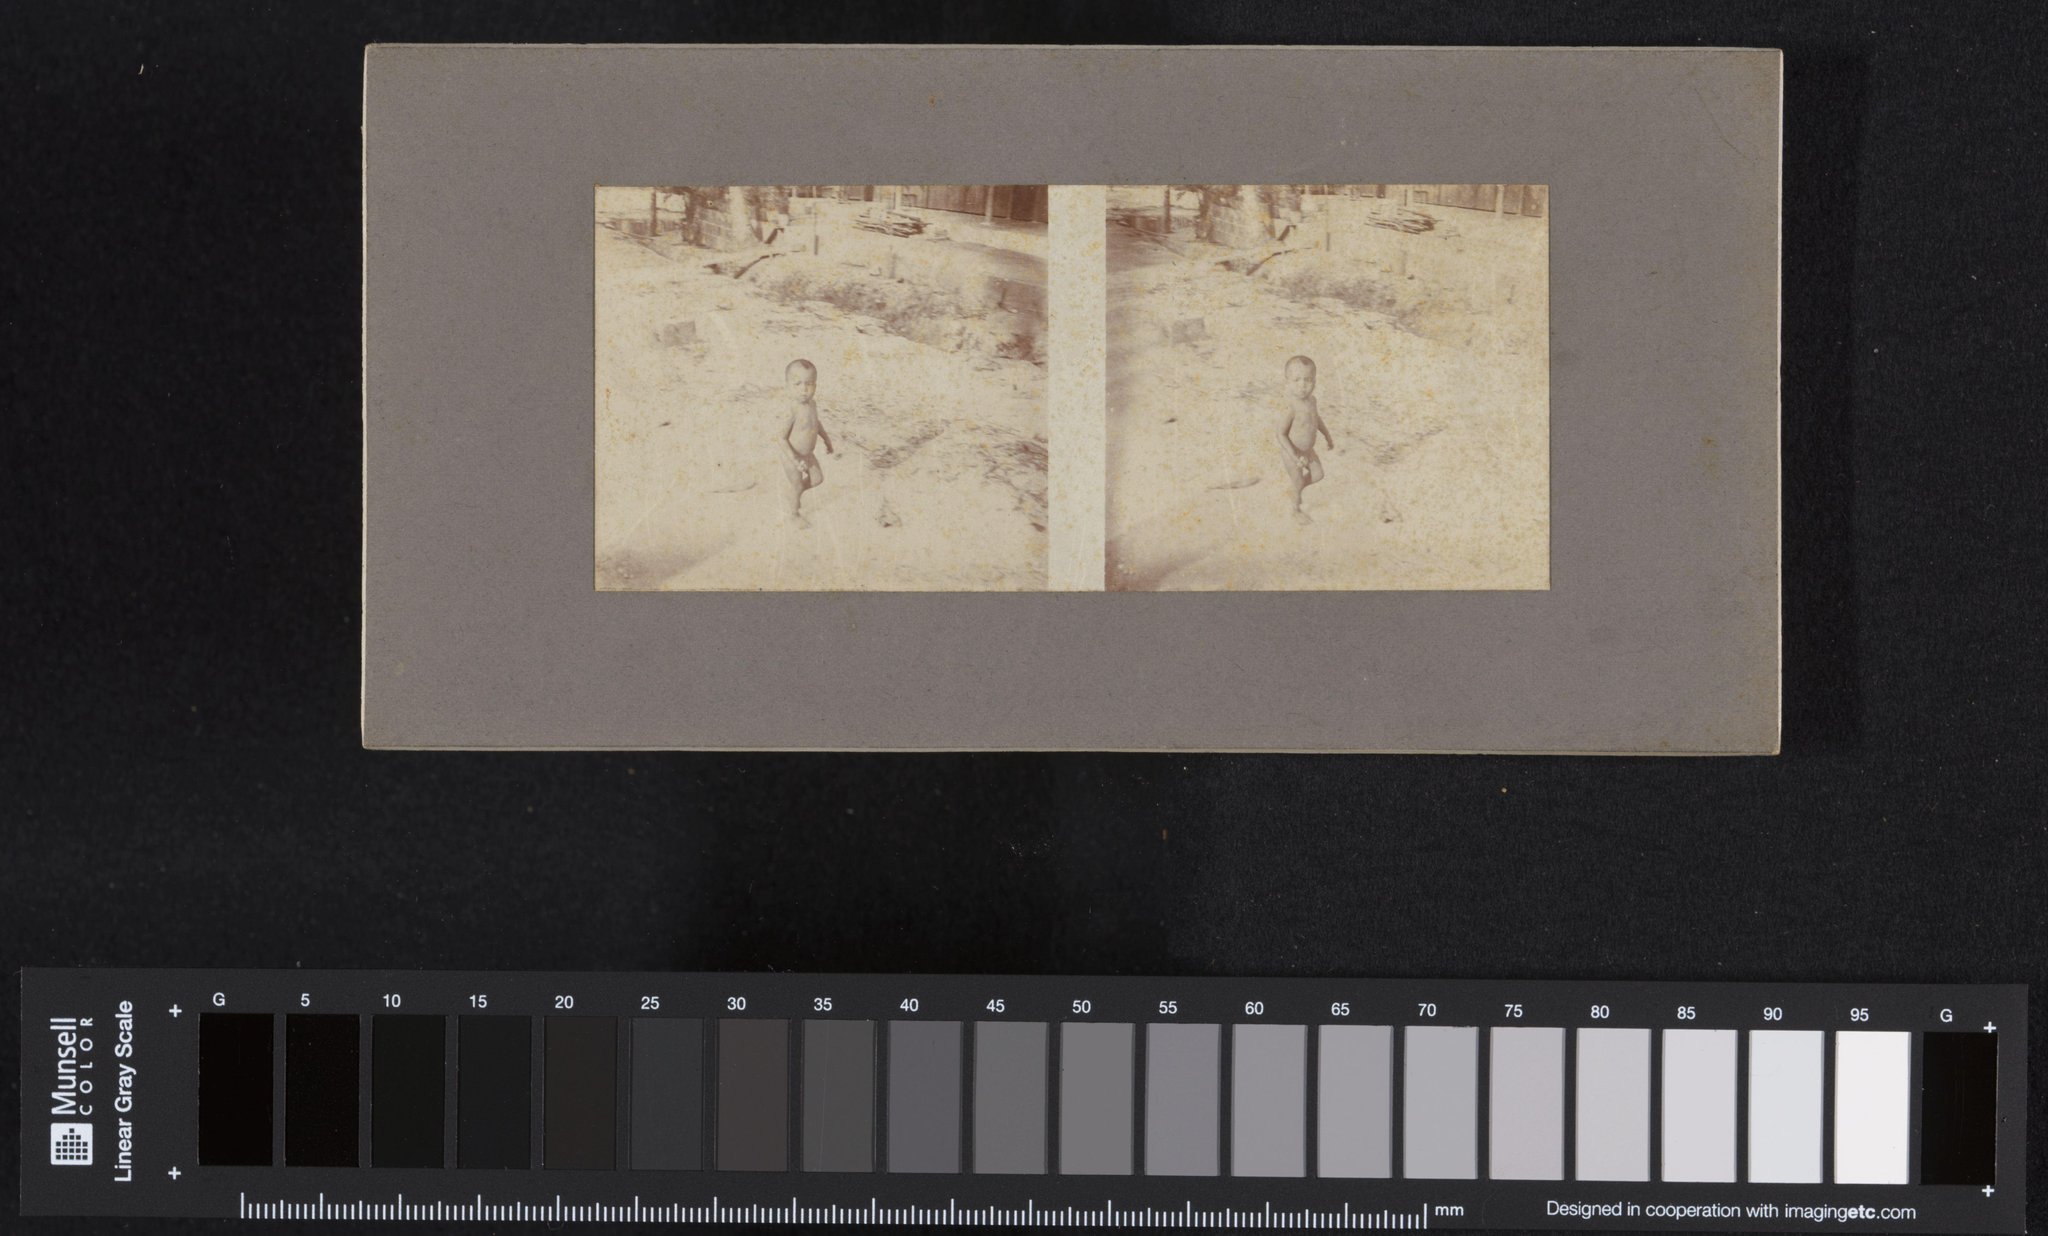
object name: stereograph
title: Jongetje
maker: robert julius boers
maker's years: 1867-1932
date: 1900-1922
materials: cardboard, photographic support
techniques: gelatin silver print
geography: bangka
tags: robert julius boers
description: Een Indisch jongetje langs een weg op Banka. Onderdeel van een groep stereofoto's van Robert Julius Boers, chef van het staatsbedrijf de Banka-tinwinning op Banka, uit de periode ca. 1900-1922.